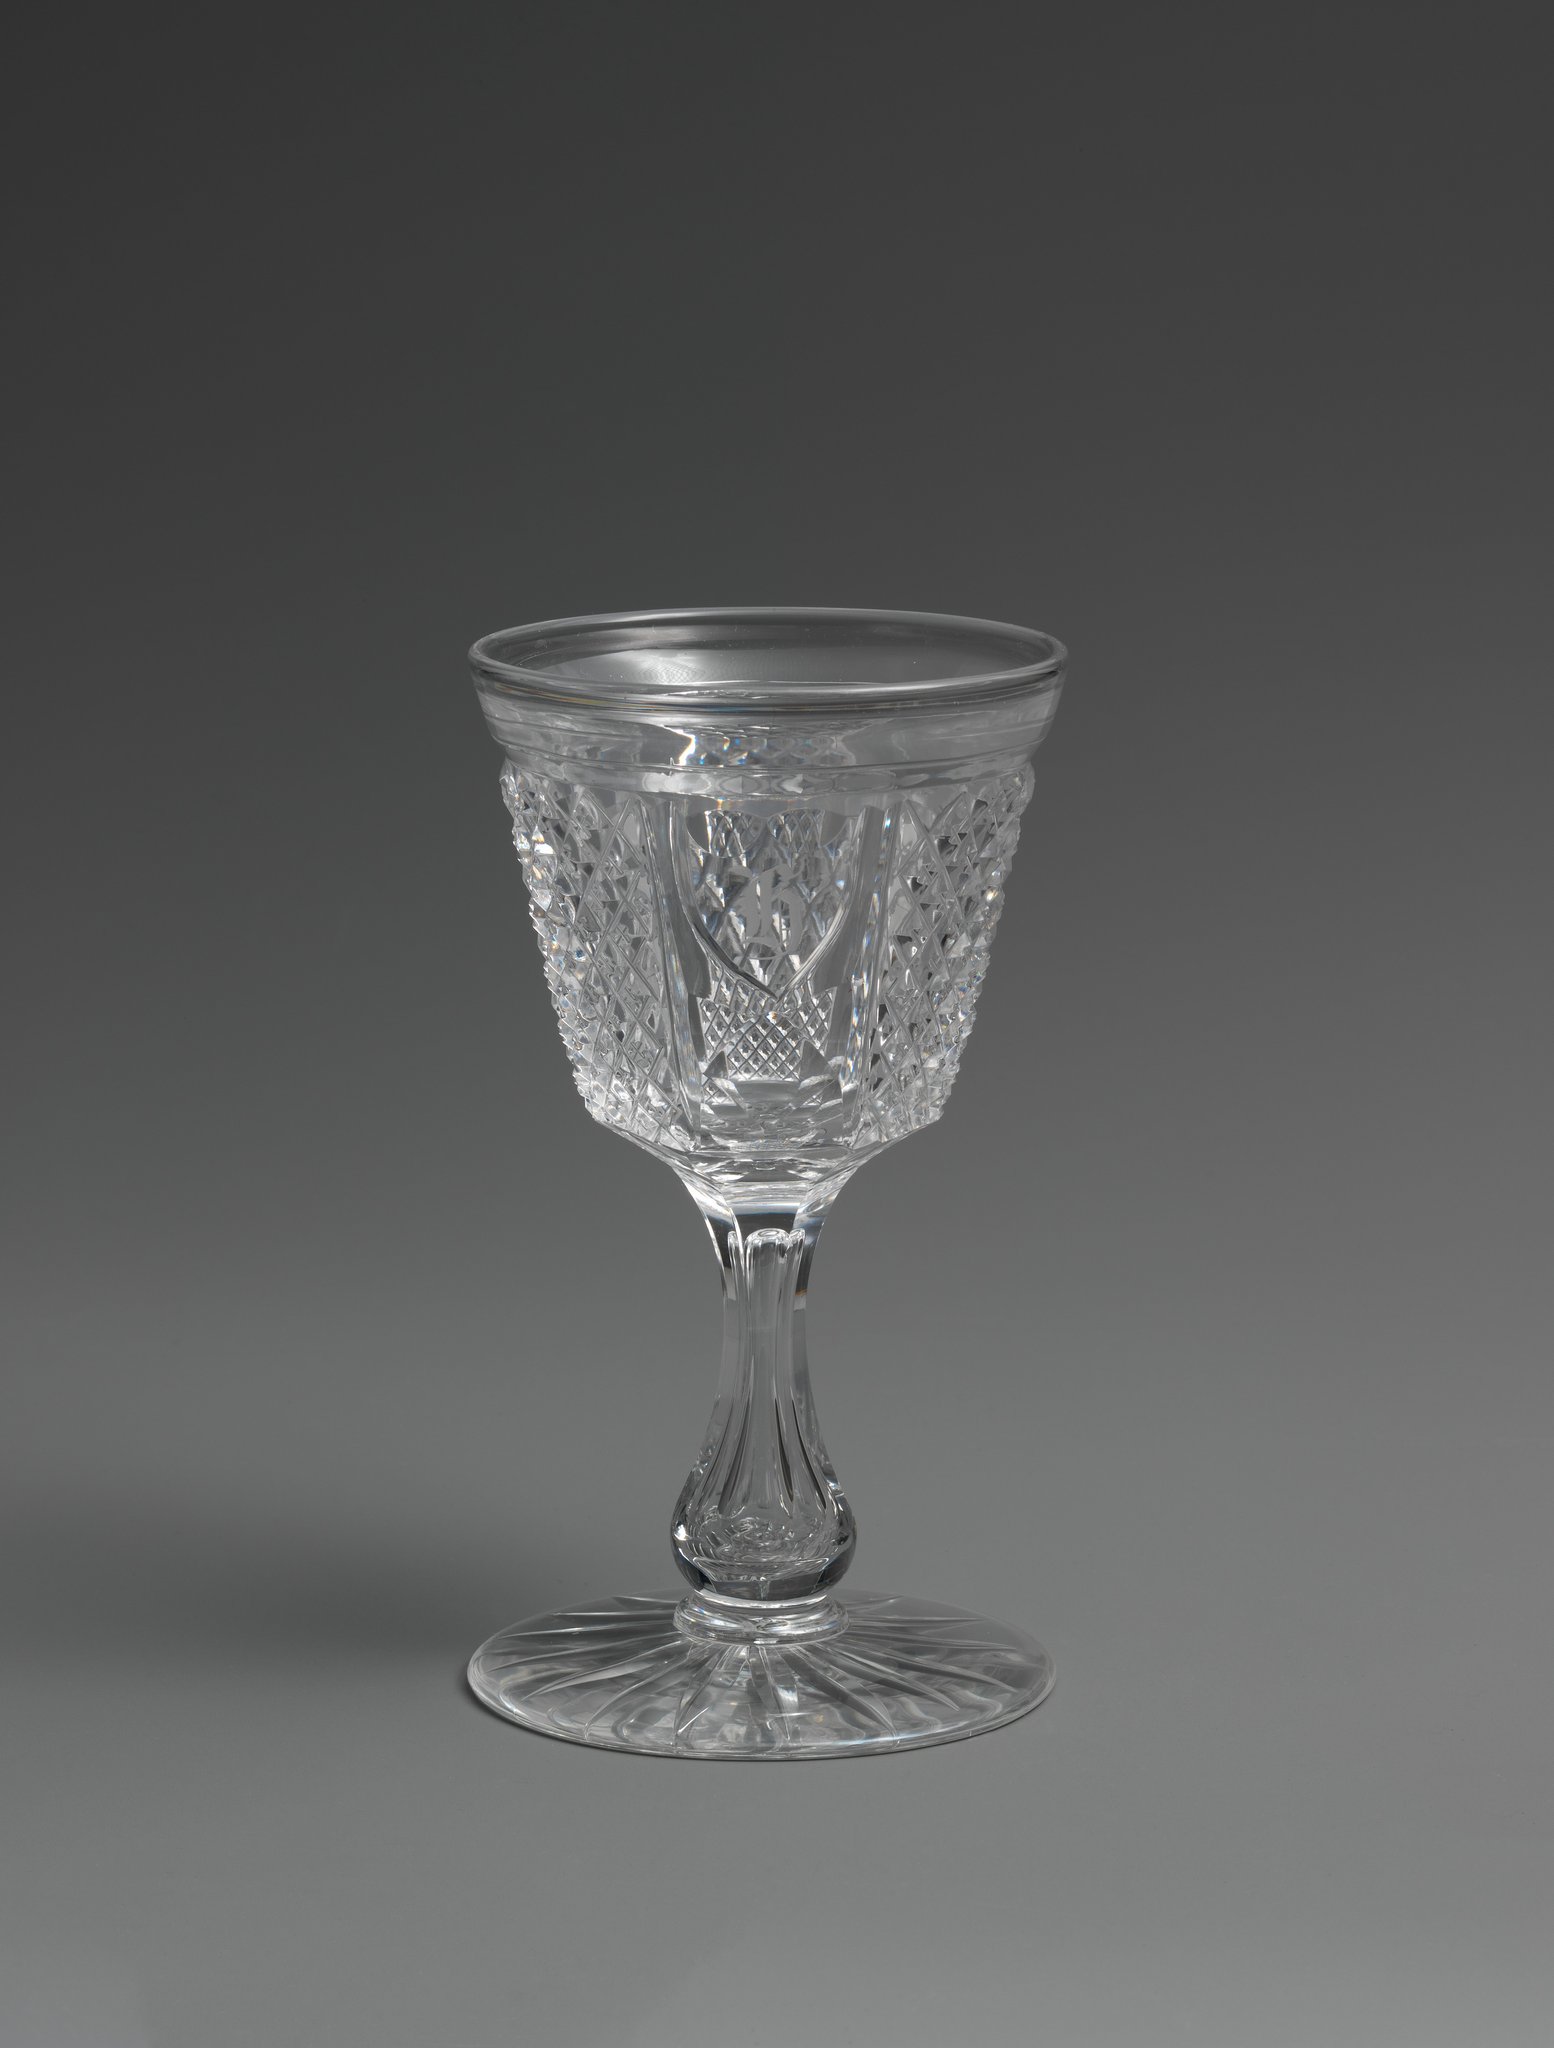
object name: drinking vessel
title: Medium drinking vessel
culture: american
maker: brooklyn flint glass company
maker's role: manufacturer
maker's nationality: american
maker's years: 1824-1868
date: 1855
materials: glass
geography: united states